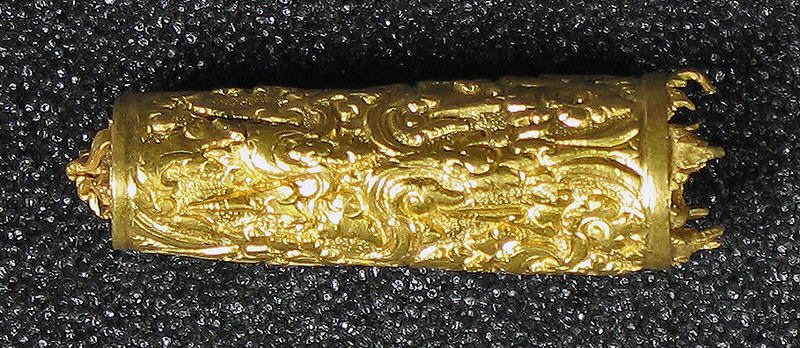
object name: pendant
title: Pendant, Tapering Cylinder, Foliate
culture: indonesian, central java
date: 701-1200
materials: gold